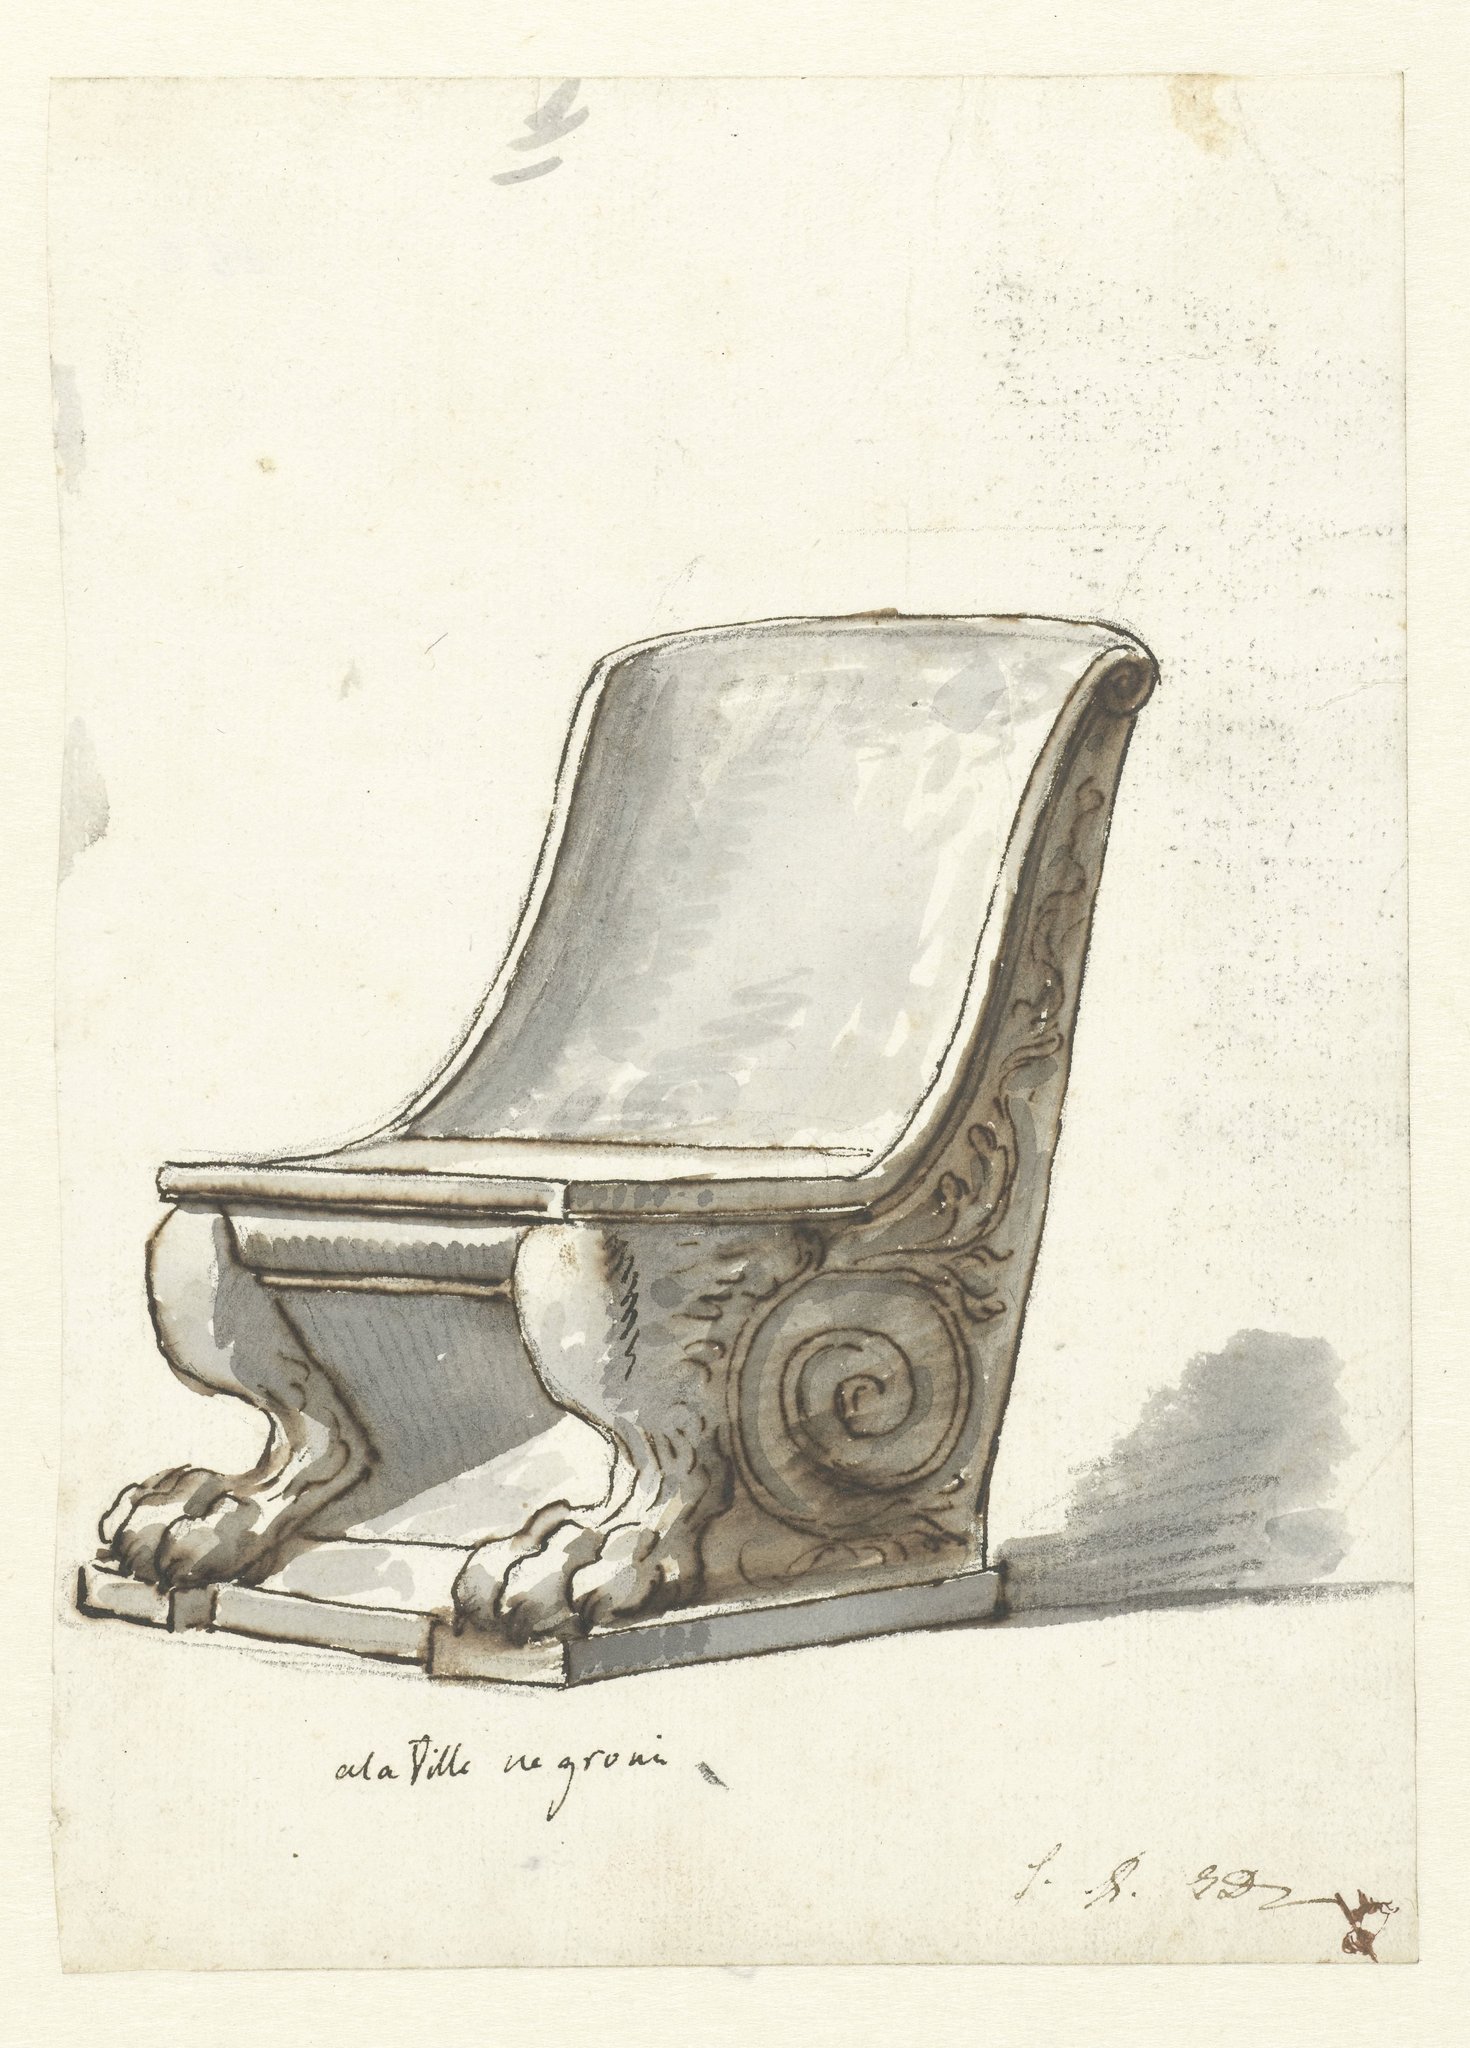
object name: drawing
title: Antique Chair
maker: jacques-louis david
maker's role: draughtsman, painter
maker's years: 1748-1825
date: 1775-1780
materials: chalk, ink, paper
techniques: brush, pen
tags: villa montalto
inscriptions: inscription, recto, lower centre, pen and black ink: ‘a la Villa negroni’, collector's mark, verso, centre, to the right: Lugt 2228, collector's mark, recto, lower right, pen and brown ink: ‘J.D.’ 1437, collector's mark, recto, lower right: Lugt 3893, collector's mark, recto, lower right, pen and brown ink: ‘ED.’ Lugt 839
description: The famous painter David drew this well-known chair from Roman antiquity during his sojourn in Rome. He made use of it when at a later time he wished to depict authentic furniture in his history paintings with subjects from Roman times. David himself also designed furniture in a severe classical style.